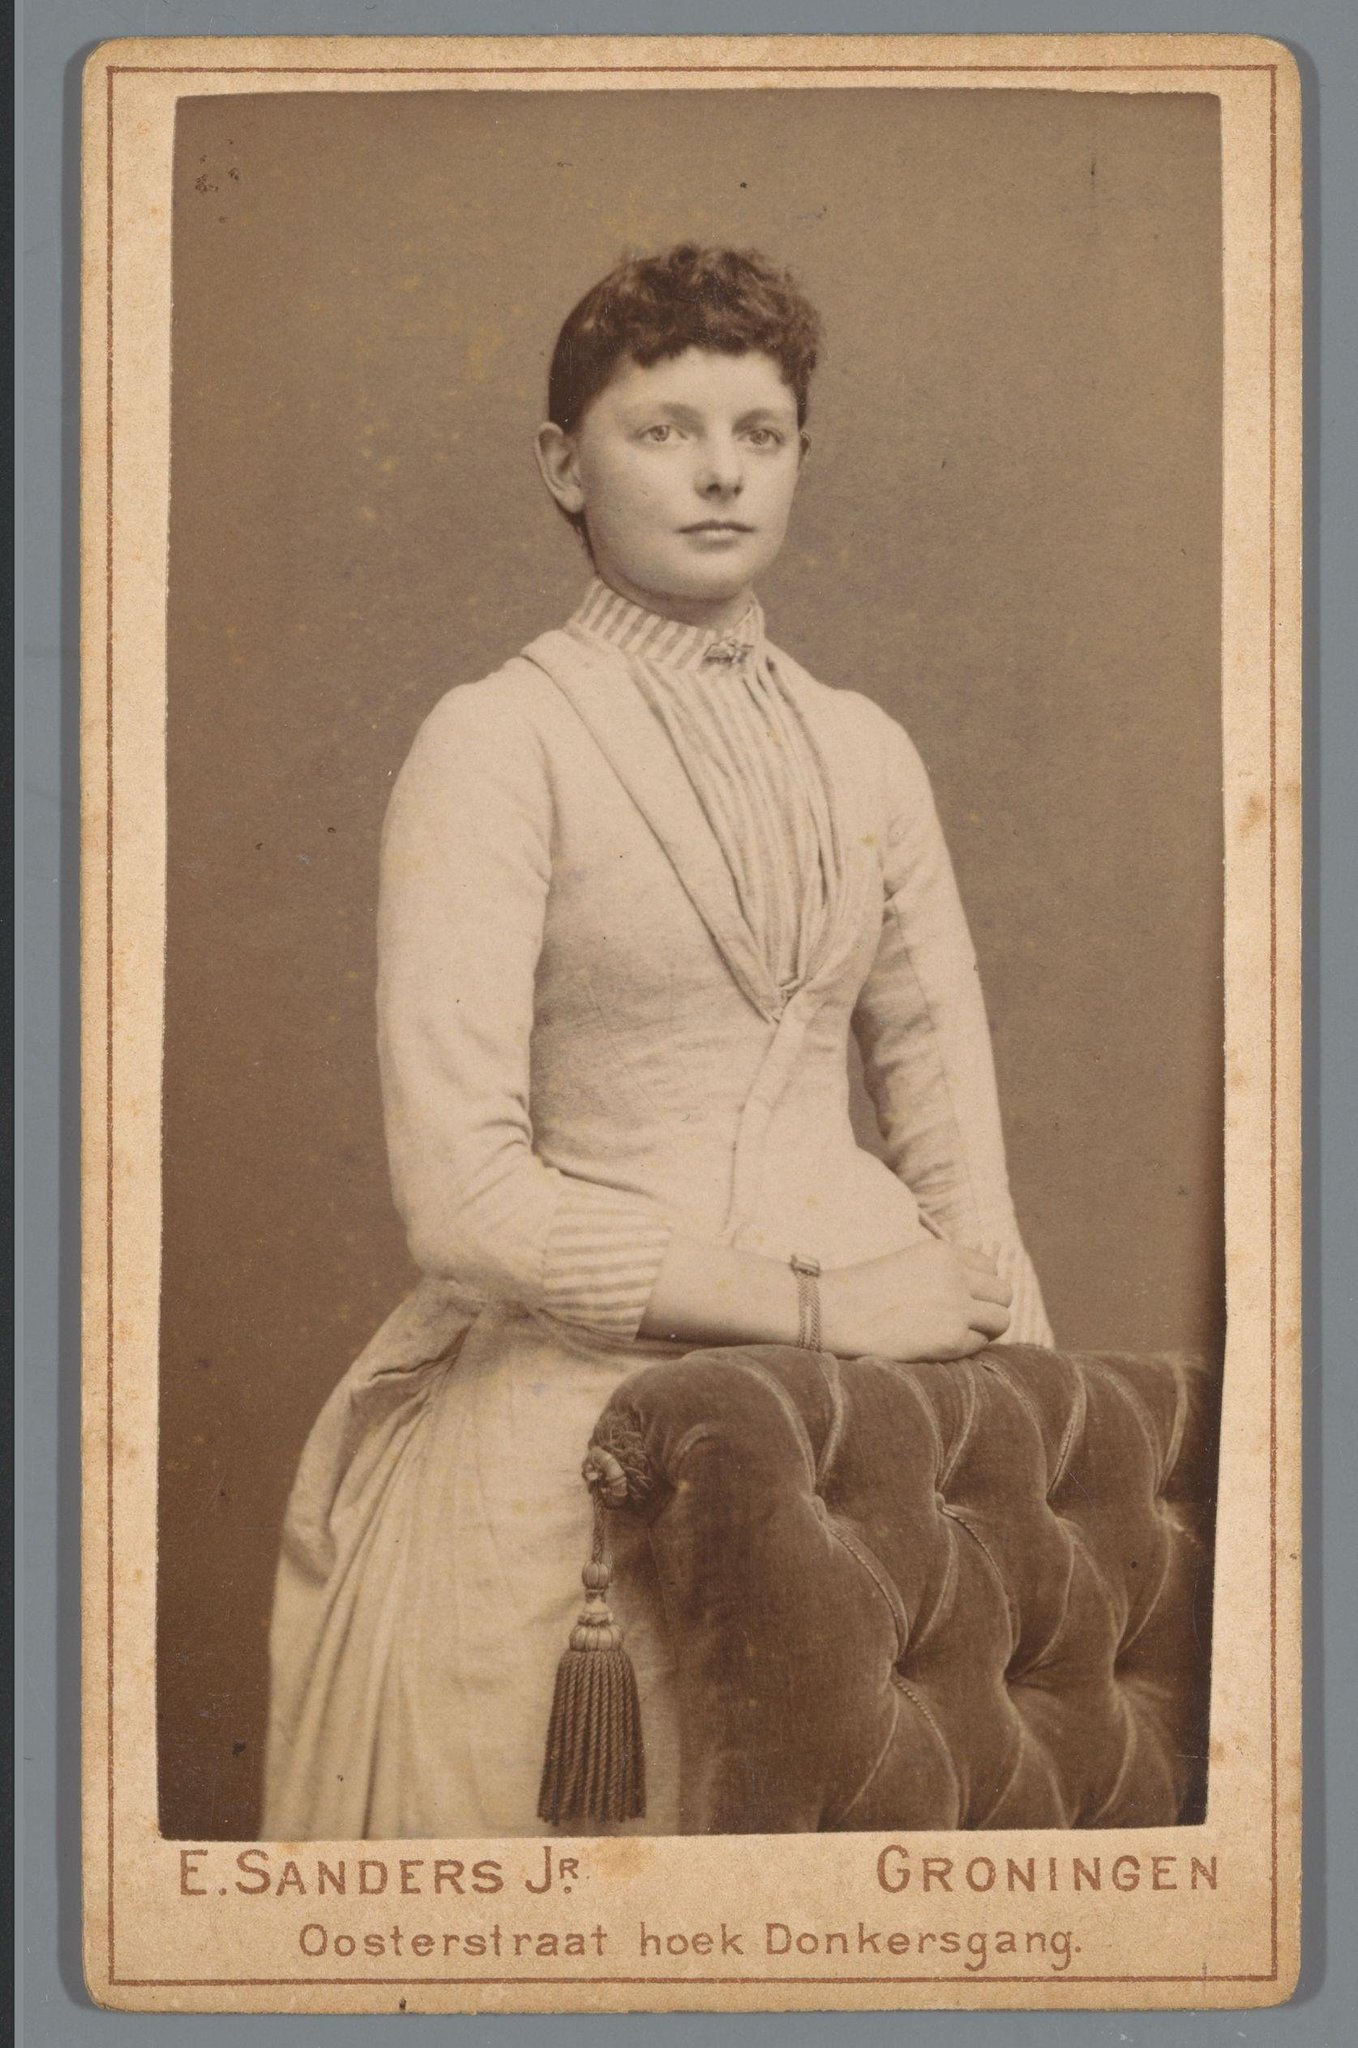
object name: carte de visite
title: Portret van Antje Bouman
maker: elkan sanders jr.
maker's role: fotograaf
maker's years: 1848-1932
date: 1886-1891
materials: cardboard, paper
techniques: albumen print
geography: groningen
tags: historical persons - bb - woman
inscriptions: inscription: ‘Elkan Sanders Jr./ GRONINGEN/ Oosterstraat/ 204/ hoek Donkersgang.’, inscription: ‘Antje Bouman/ get. met/ Ellema/ Usquert’